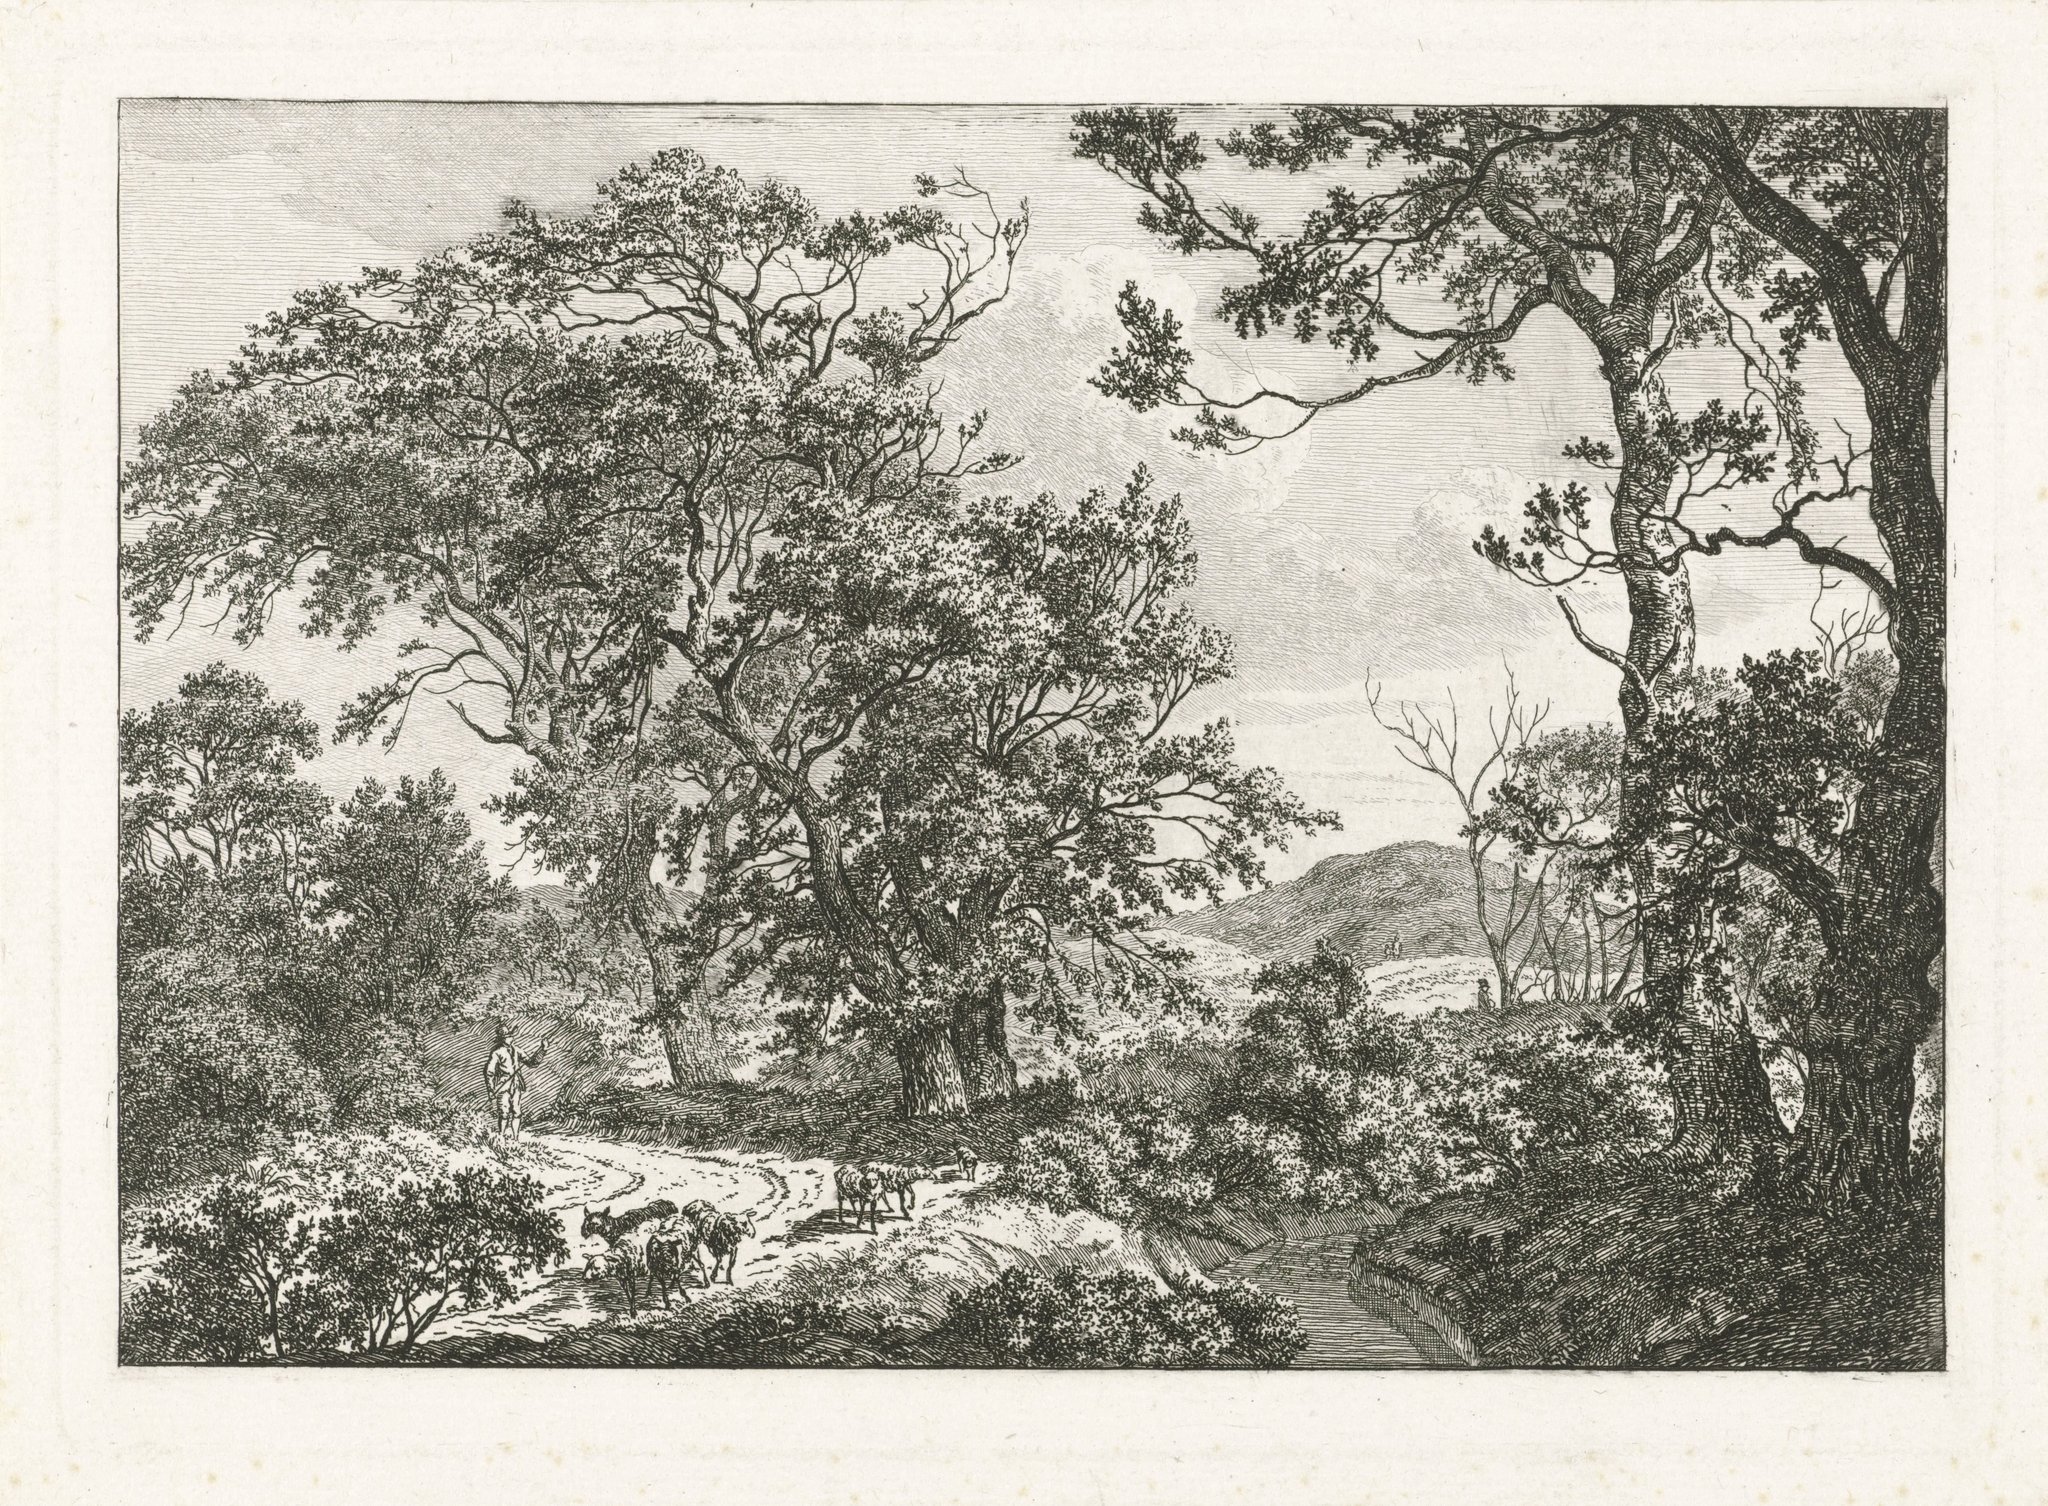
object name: print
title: Landschap met herder met schapen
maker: franciscus andreas milatz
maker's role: draughtsman, painter, print maker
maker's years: 1764-1808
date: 1784-1808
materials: paper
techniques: etching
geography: haarlem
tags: trees, herding, herdsman, herdswoman, shepherd, shepherdess, cowherd, etc., dunes (sea not visible); in the dunes, sheep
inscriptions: collector's mark: Lugt 2228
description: Duinlandschap met geboomte langs een weg. Op de weg een herder met schapen.